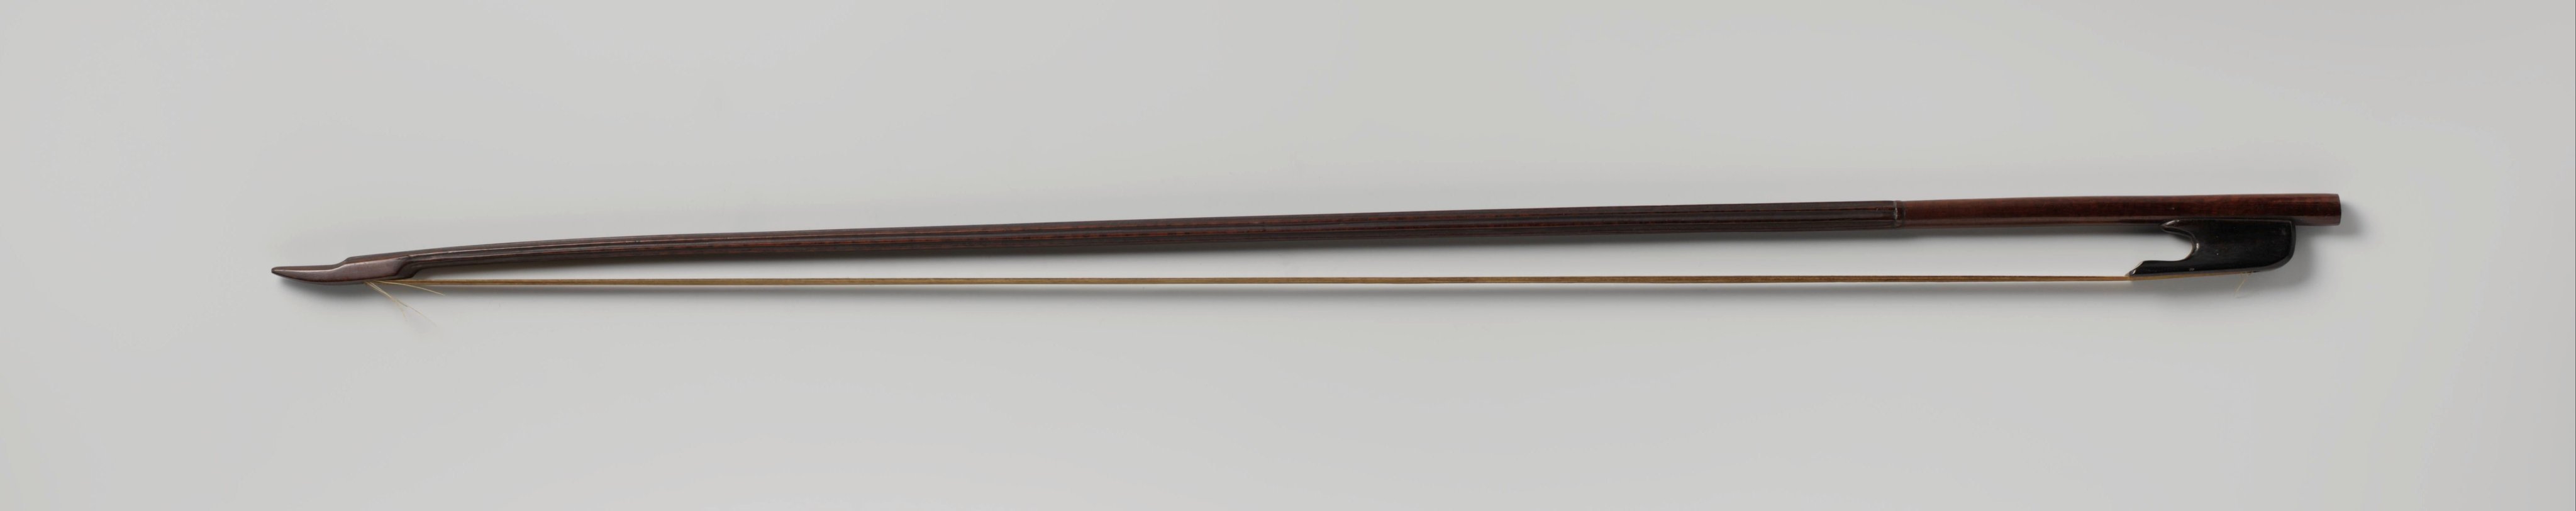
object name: musical instrument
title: Bow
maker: Anonymous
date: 1700-1800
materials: wood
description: Gecanneleerde strijkstok horend bij vijf stokken (BK-NM-11430-34-A t/m BK-NM-11430-34-F).